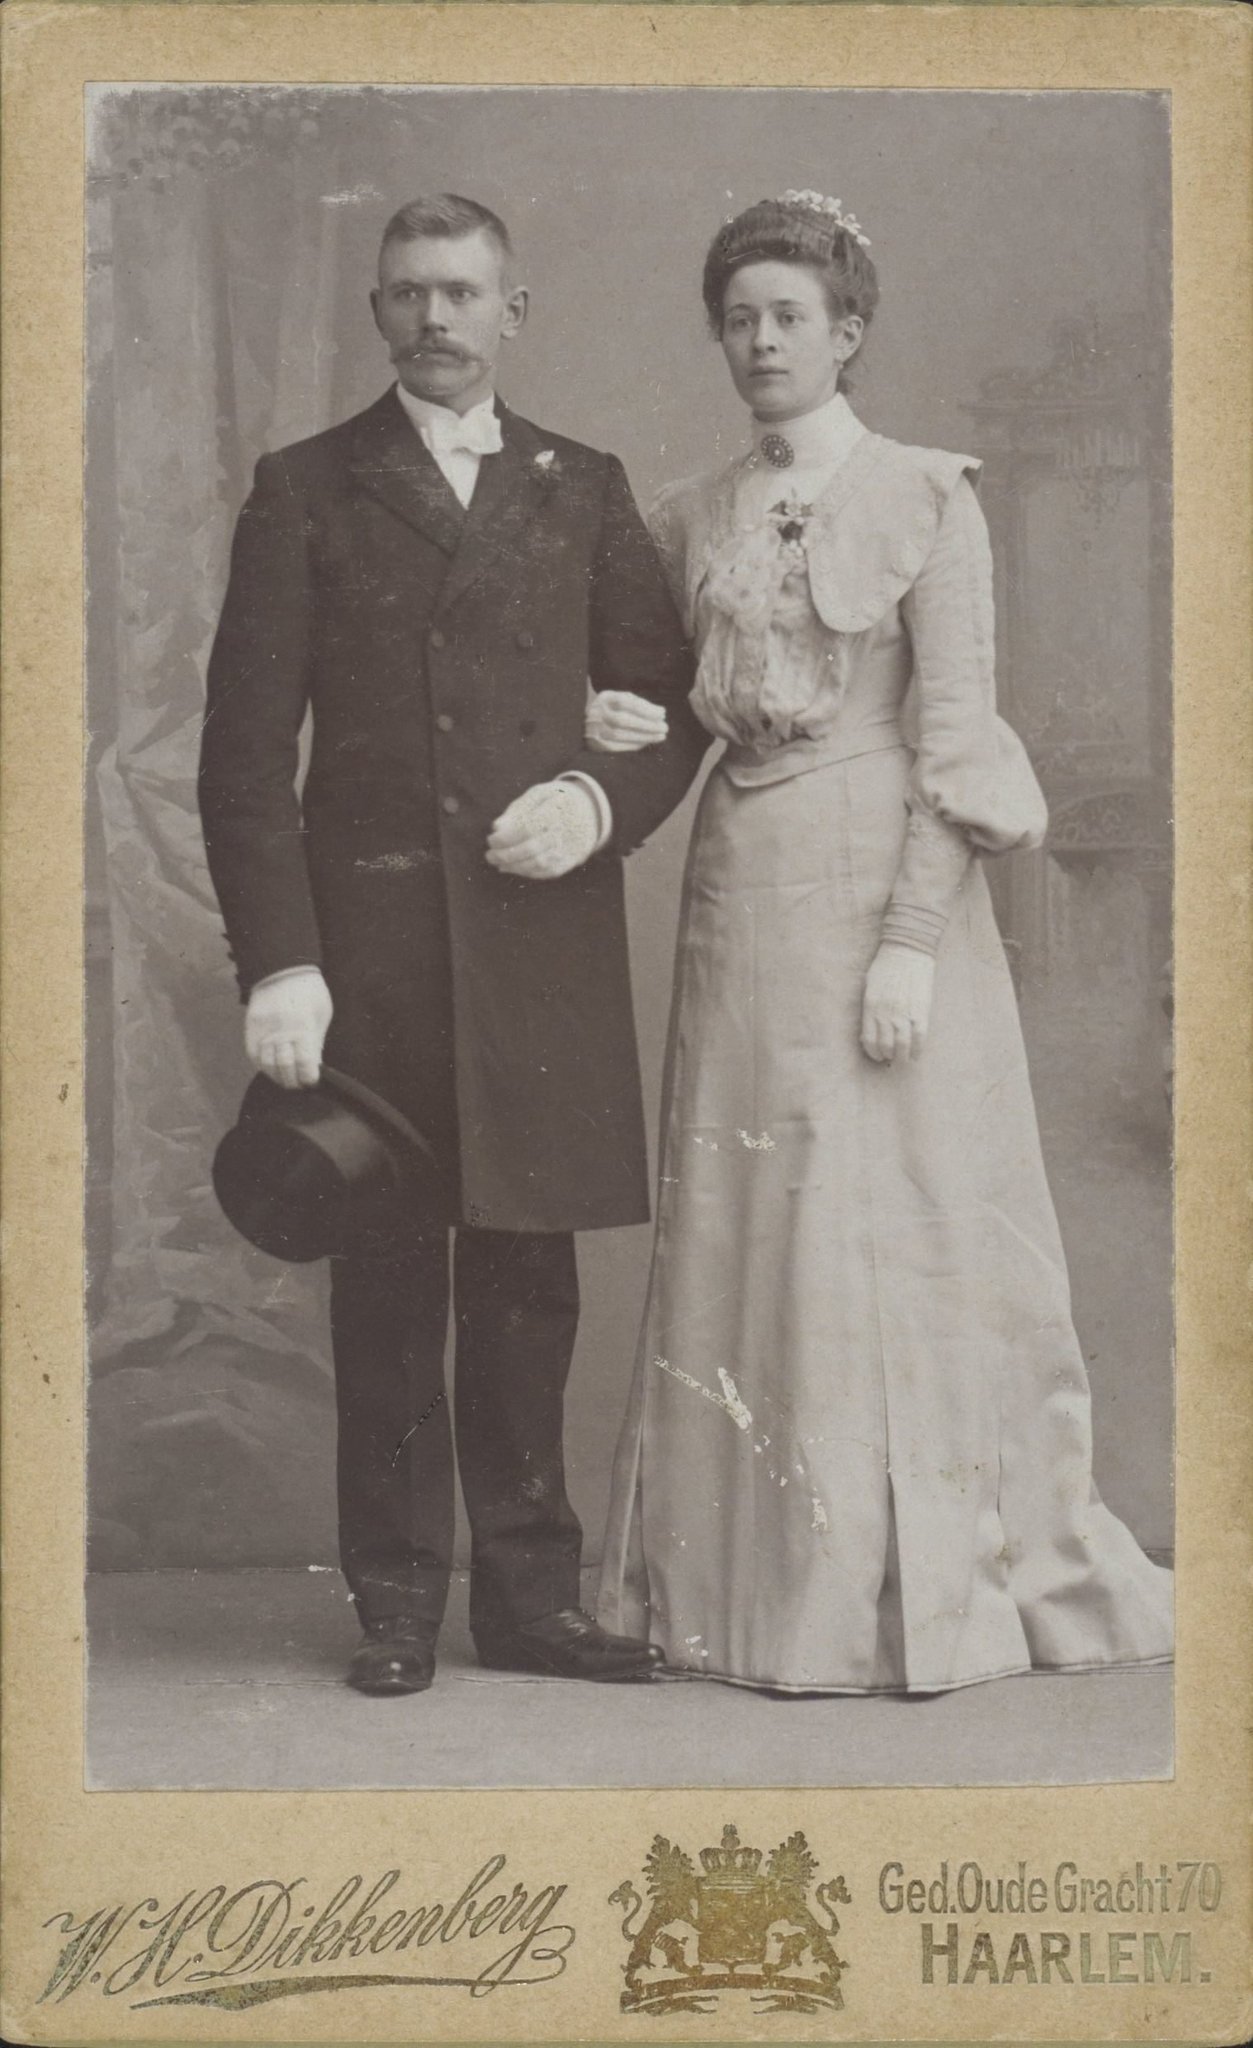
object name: carte de visite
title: Portret van een echtpaar, staand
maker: willem hendrik dikkenberg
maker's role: fotograaf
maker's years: 1872-1946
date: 1900-1905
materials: cardboard, paper, photographic support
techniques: collodion silver print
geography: haarlem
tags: marriage, married couple, 'matrimonium', haarlem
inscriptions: address: ‘Ged. Oude Gracht 70 Haarlem’, date: ‘1900-1905’